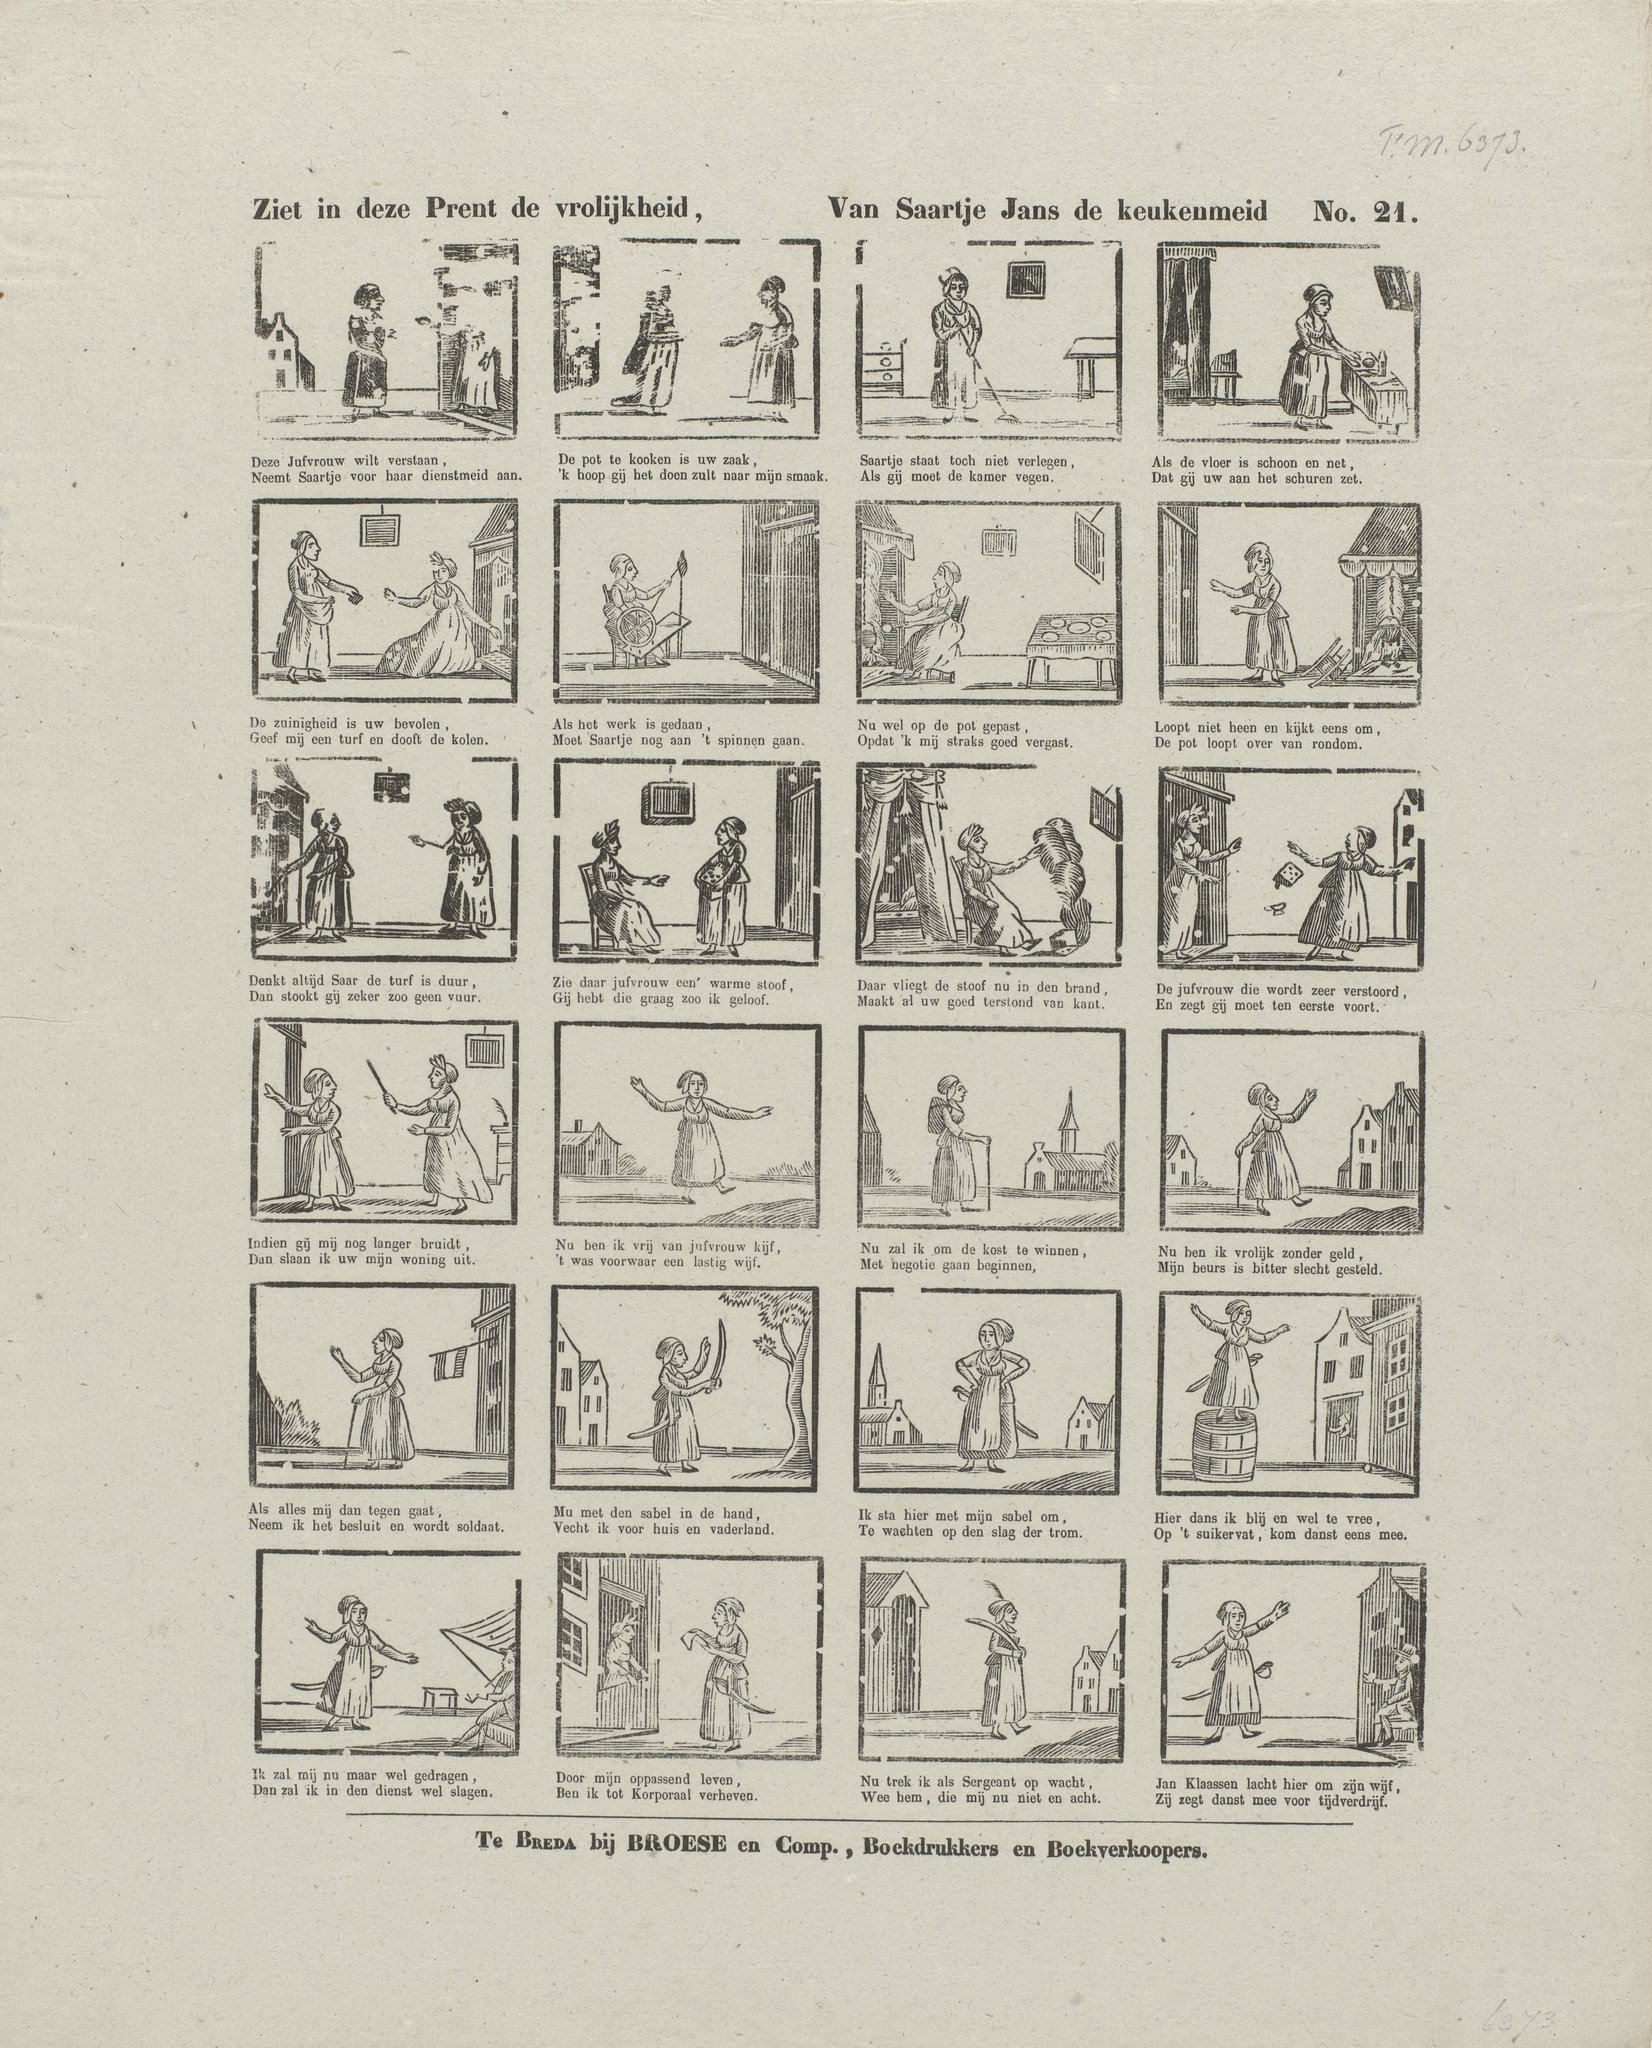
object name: print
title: Ziet in deze prent de vrolijkheid, / Van Saartje Jans de keukenmeid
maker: Anonymous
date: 1828-1853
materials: paper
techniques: letterpress printing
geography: breda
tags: the soldier; the soldier's life, kitchen-maid, kitchen servant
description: Blad met 24 voorstellingen uit het leven van Saartje Jansz.. In de eerste scènes werkt zij als keukenmeid, maar wordt ontslagen omdat zij teveel van de dure turf gebruikt voor het koken. Daarna wordt zij soldaat. Onder elke afbeelding een tweeregelig vers. Genummerd rechtsboven: No. 21.